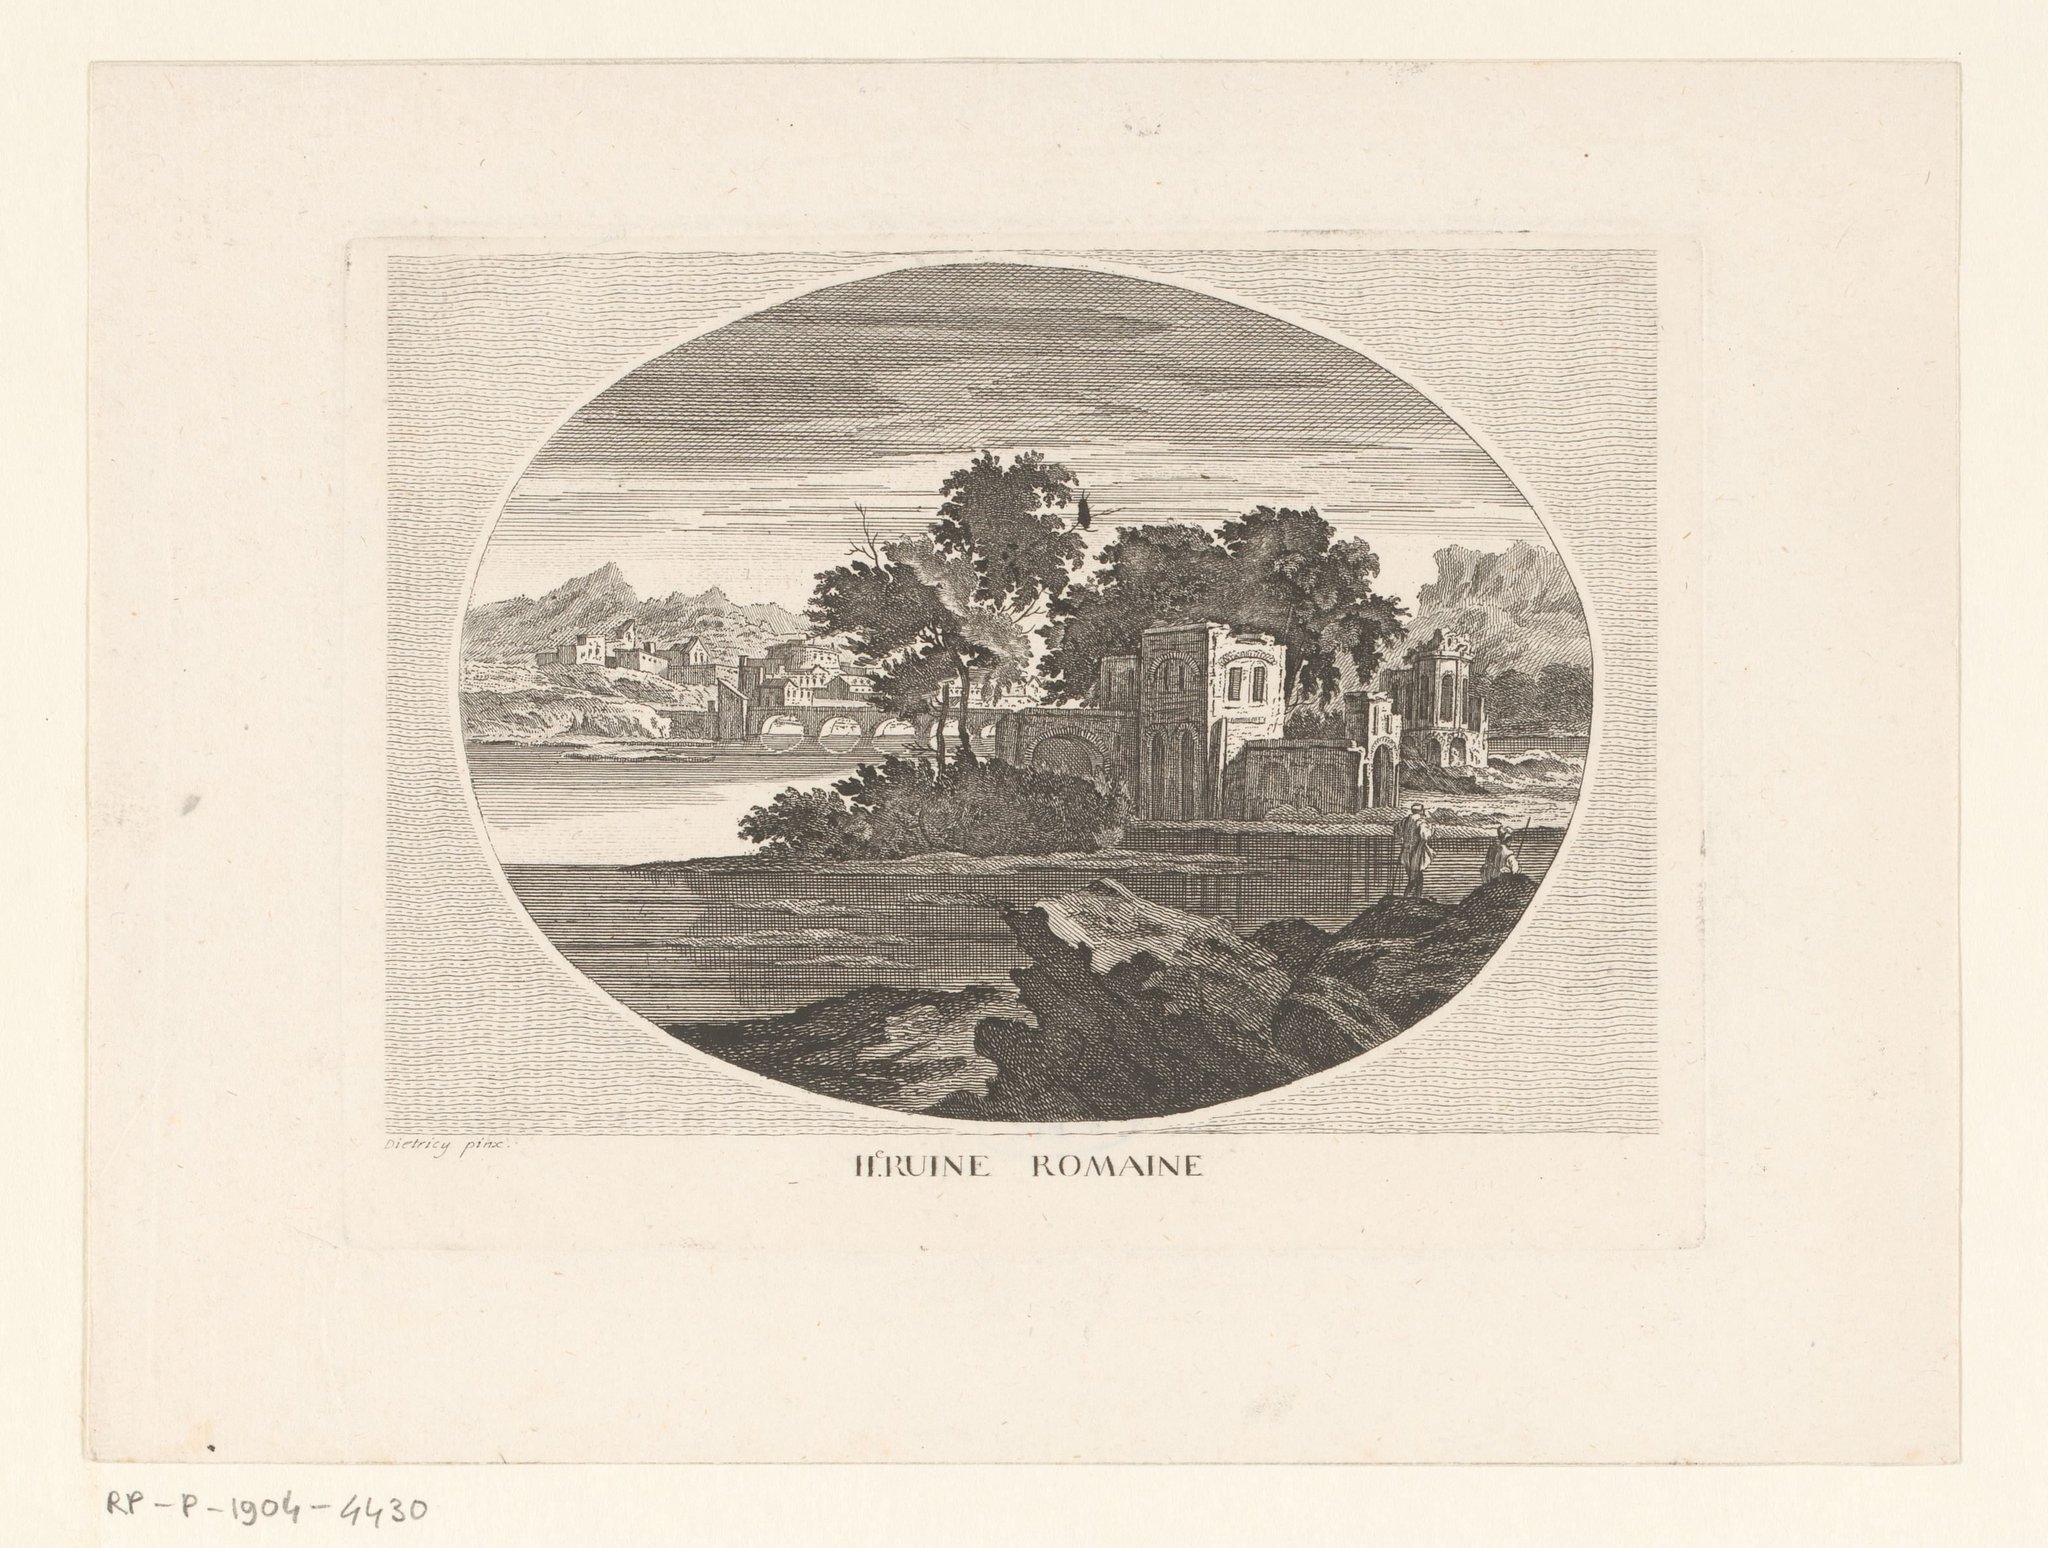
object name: print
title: Romeinse ruïne op een eiland in een rivier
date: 1722-1822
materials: paper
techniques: engraving, etching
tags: landscape with ruins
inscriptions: collector's mark: Lugt 2228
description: Maakt waarschijnlijk deel uit van een onbekende serie met Romeinse ruïnes.